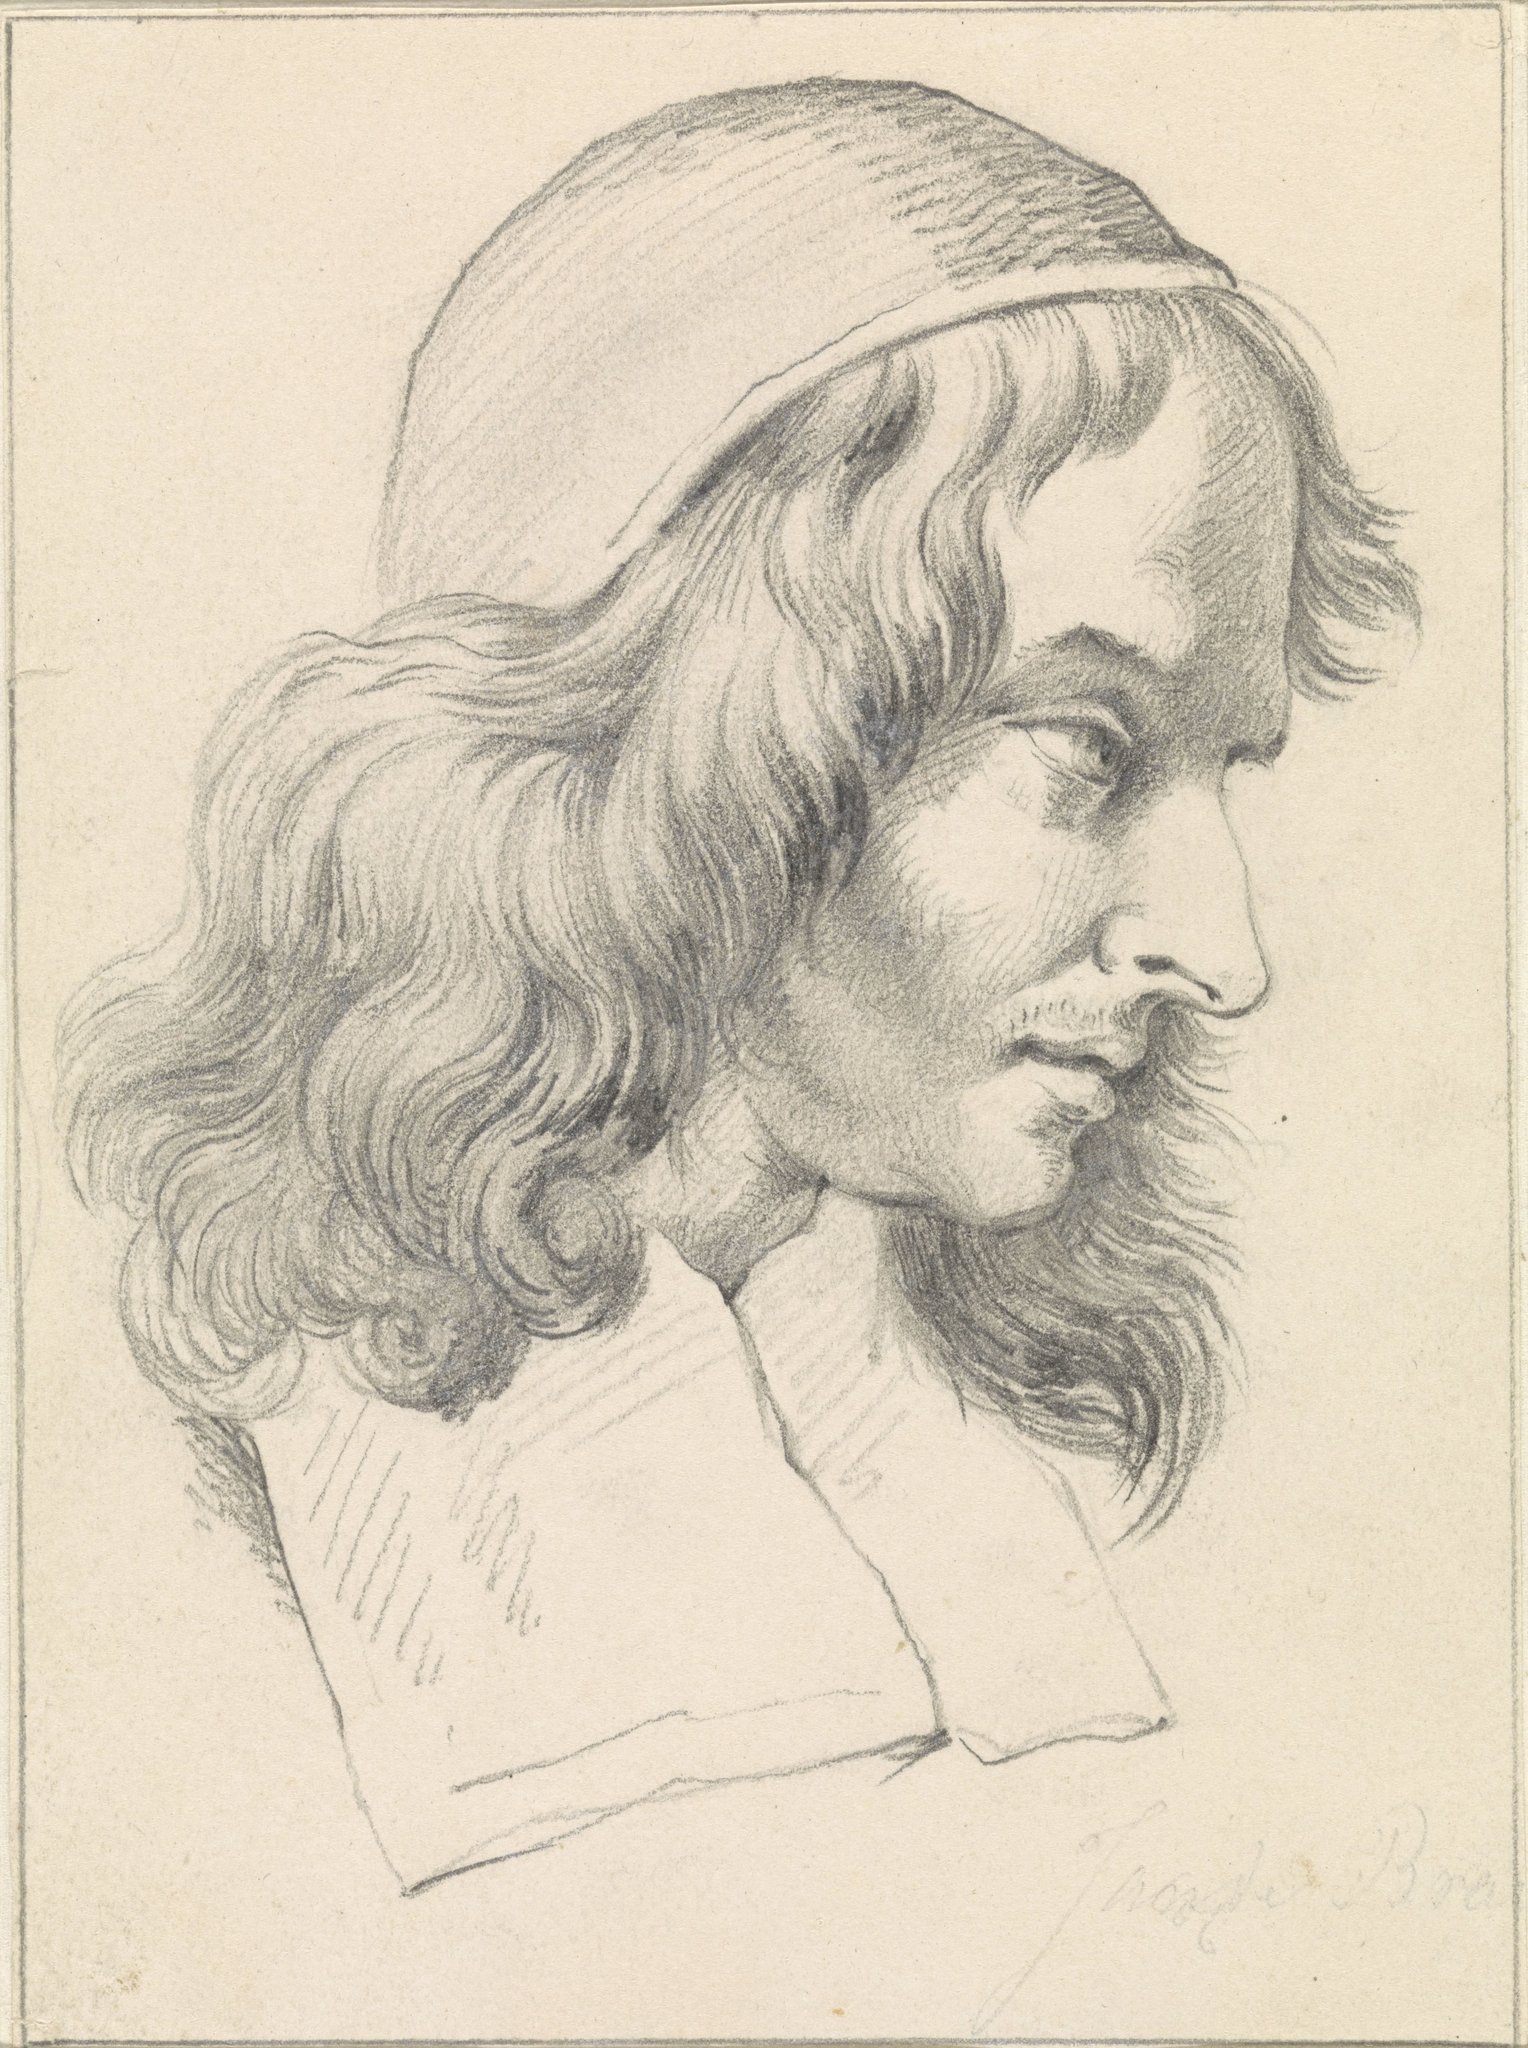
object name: drawing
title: Portrait of Jan de Bray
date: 1800-1900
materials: paper, pencil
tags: haarlem, amsterdam, print maker, draughtsman, jan de bray, historical persons, portrait, self-portrait of painter, portrait, self-portrait of artist, portrait, self-portrait of draughtsman